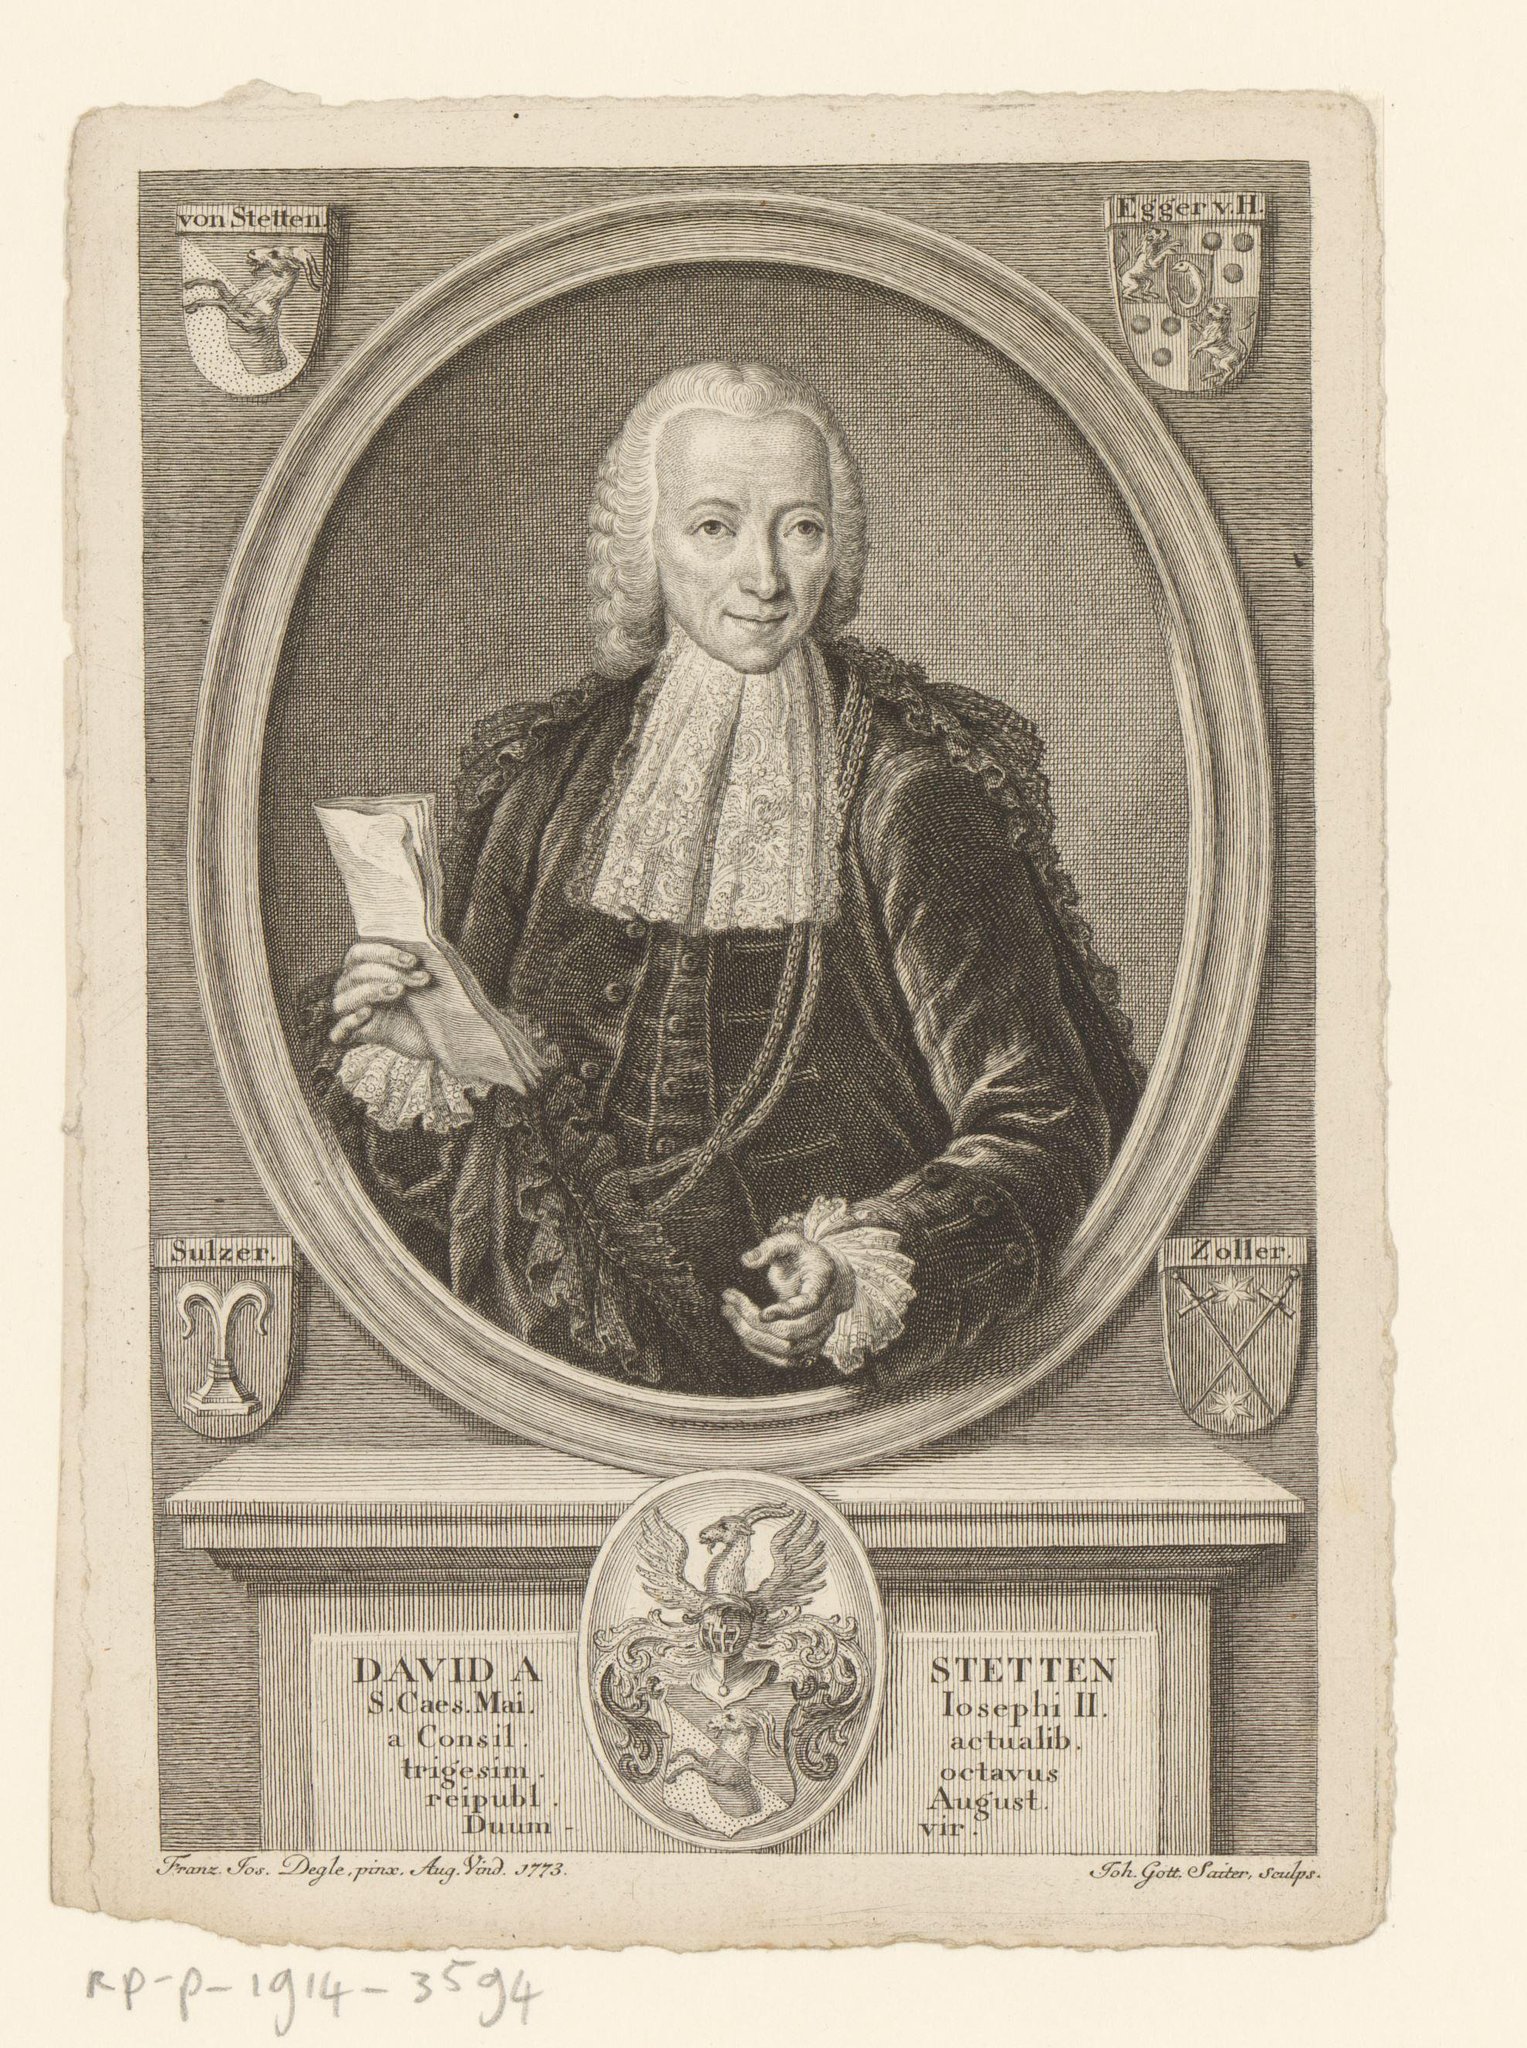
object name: print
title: Portret van David von Stetten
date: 1773-1800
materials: paper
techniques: engraving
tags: historical persons, armorial bearing, heraldry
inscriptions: collector's mark: Lugt 2228